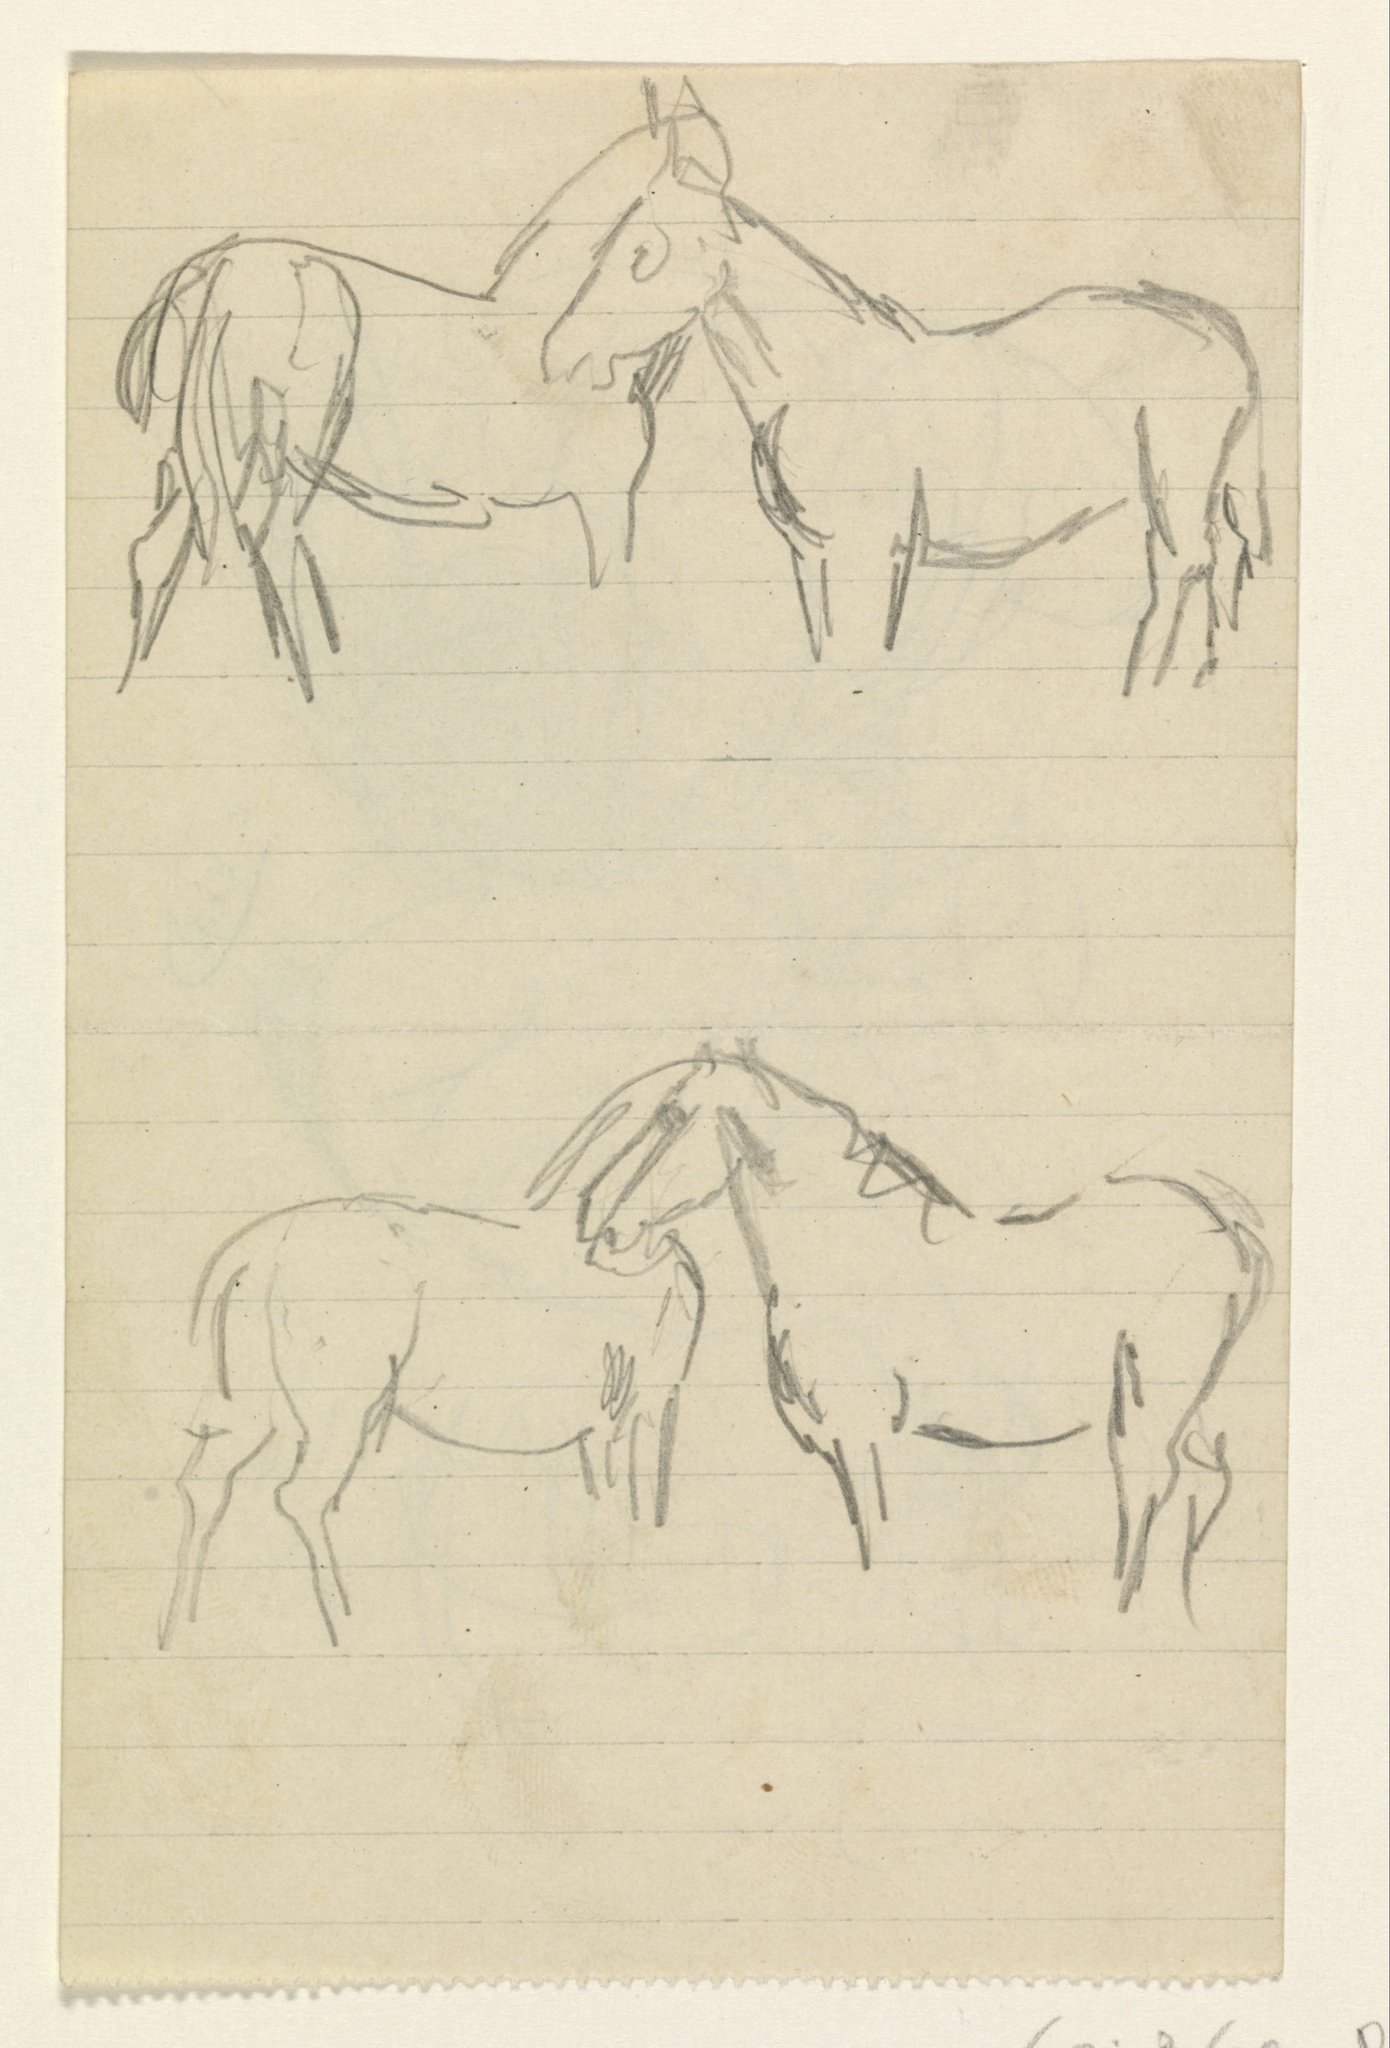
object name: drawing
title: Vier paarden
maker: leo gestel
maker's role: draughtsman, print maker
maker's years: 1881-1941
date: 1891-1941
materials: paper, pencil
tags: horse